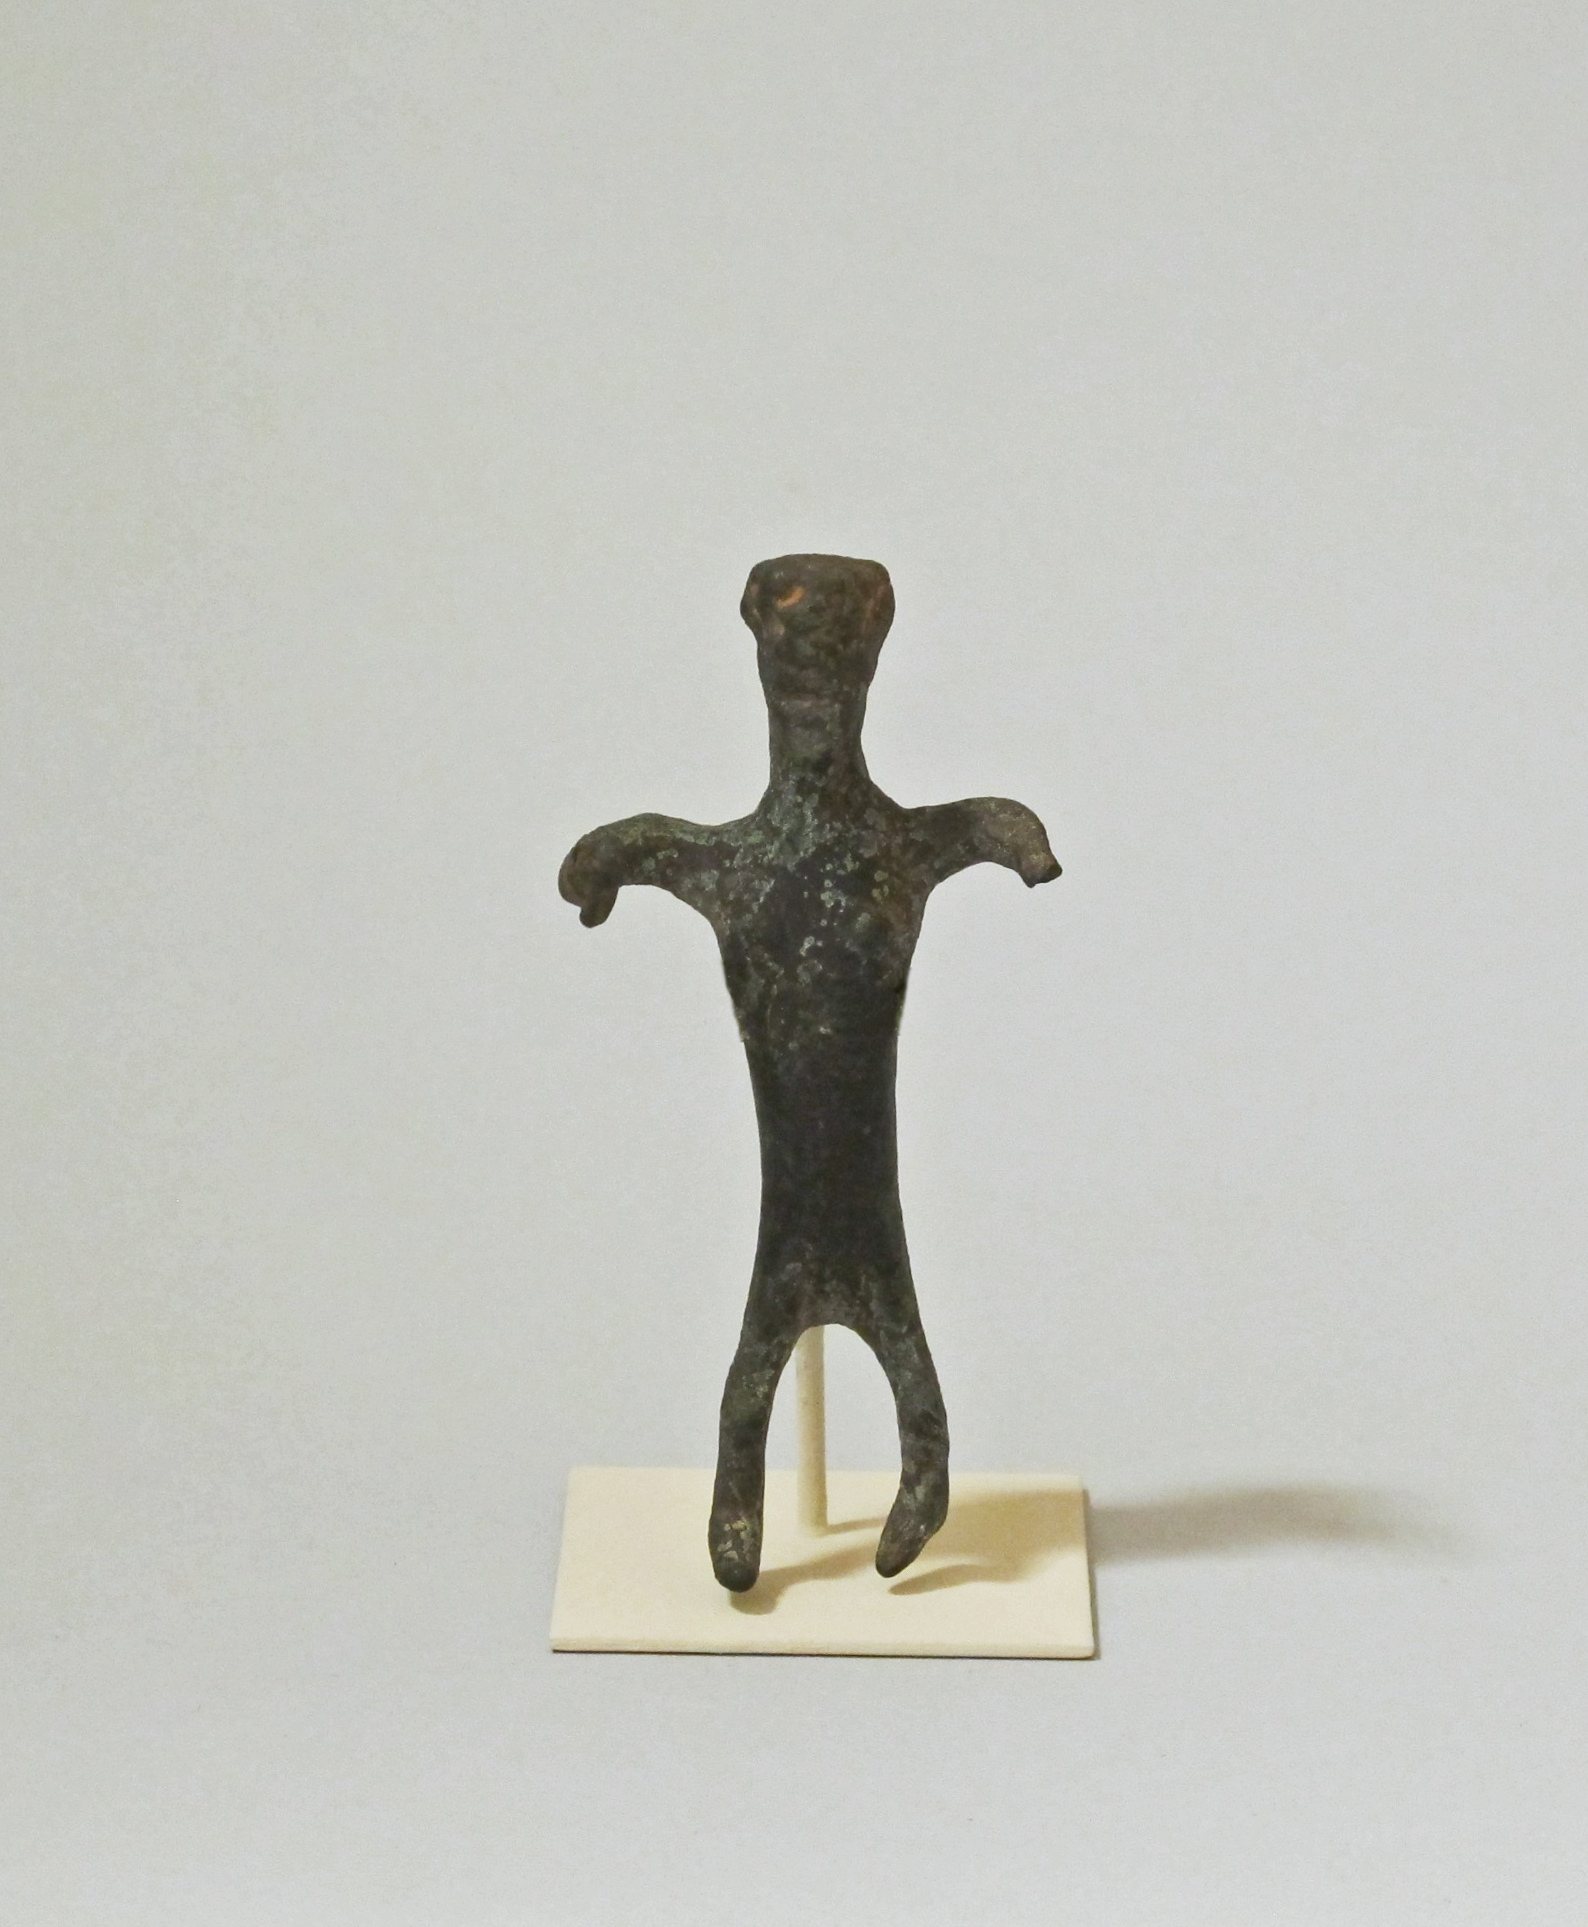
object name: statuette of a woman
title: Bronze statuette of a woman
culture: cretan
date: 1050-900 BCE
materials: bronze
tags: women